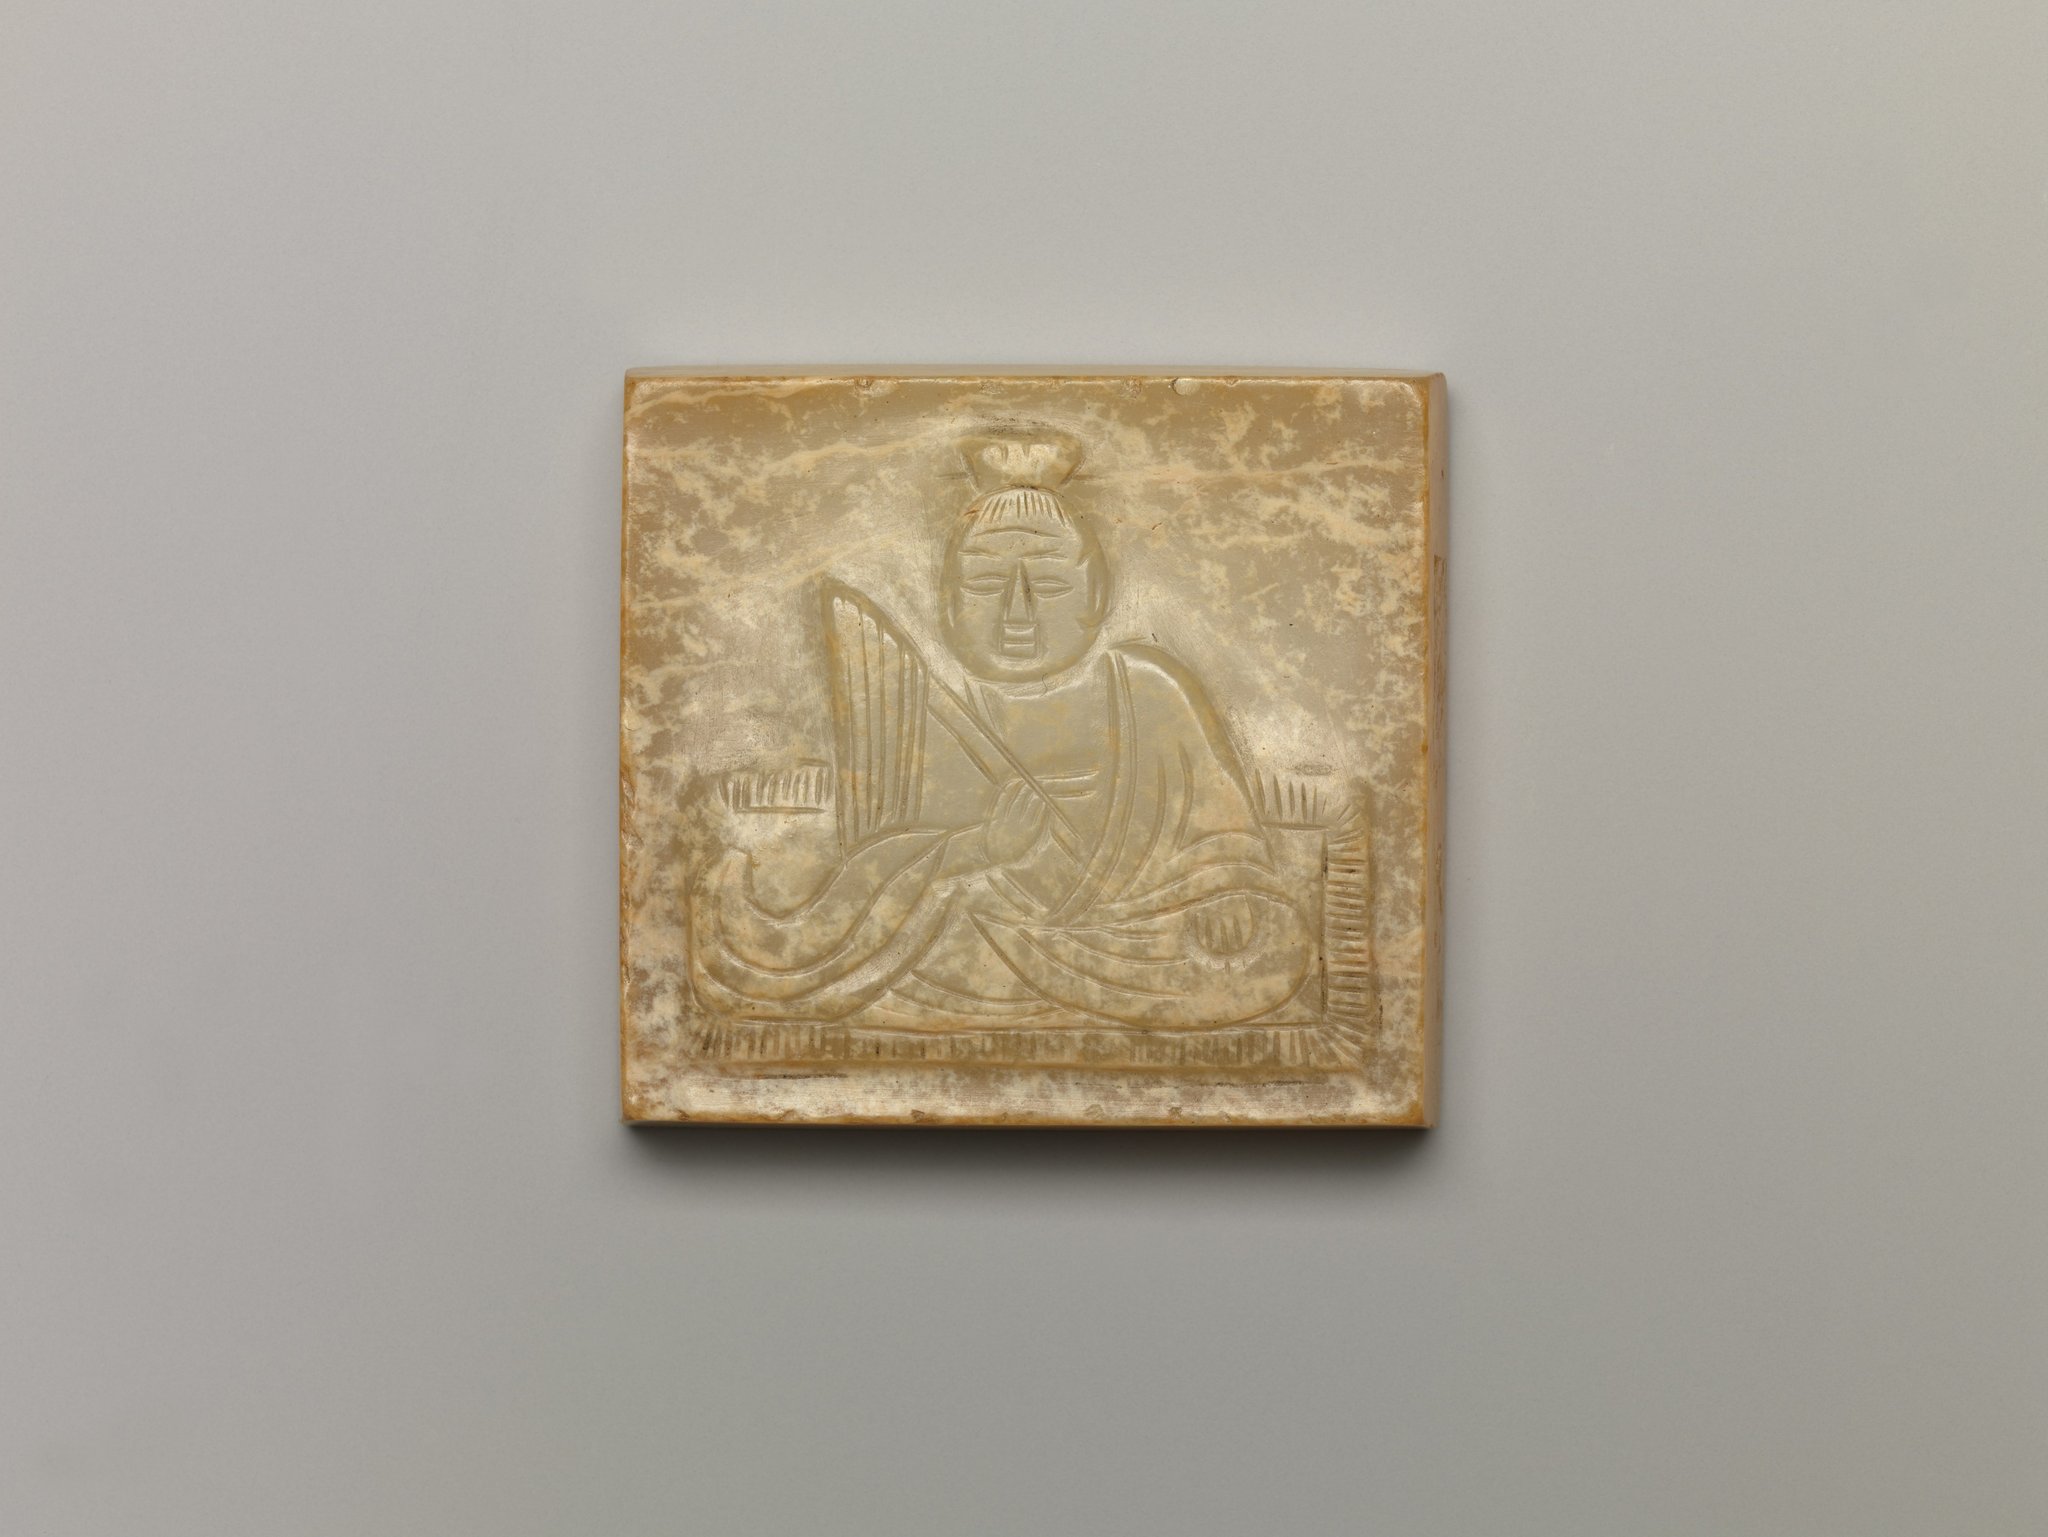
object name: belt plaque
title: Rectangular Belt Plaque with a Figure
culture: chinese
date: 960-1279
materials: jade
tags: men